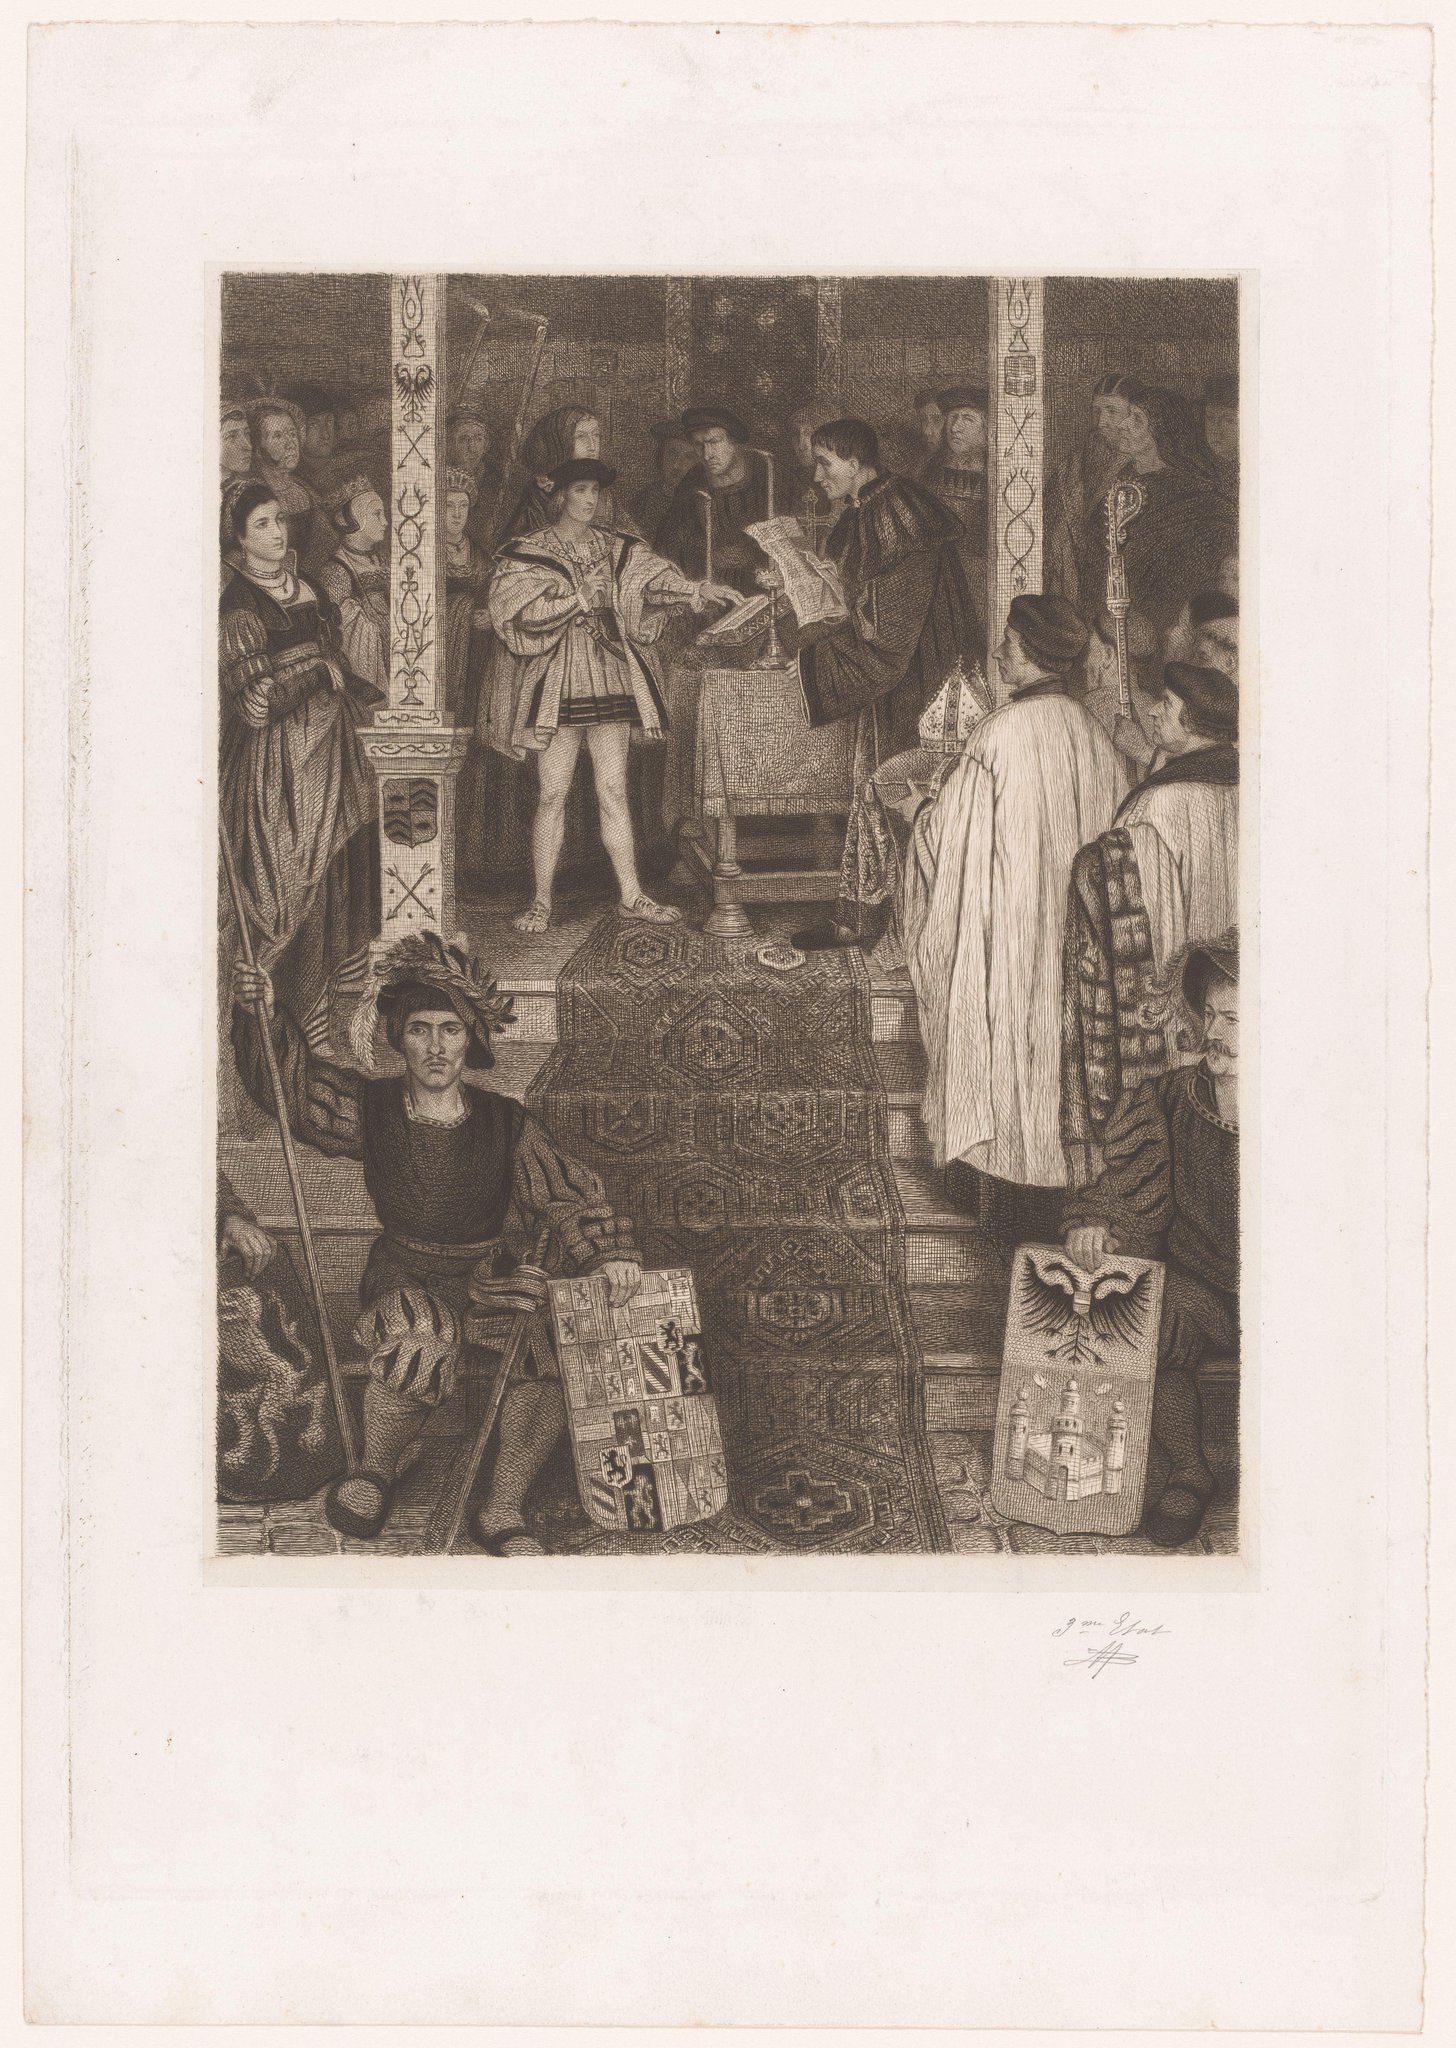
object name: print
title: Eedaflegging van keizer Karel V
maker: jean baptiste pierre michiels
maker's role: print maker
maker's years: 1821-1890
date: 1863-1890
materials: paper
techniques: etching, intaglio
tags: ghent, charles v (holy roman emperor and king of spain), ceremonial celebration of installation of a ruler, new ruler taking the oath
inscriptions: collector's mark: Lugt 2228, inscription: ‘3me Etat’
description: De prent is gemaakt naar de muurschilderingen van Henri Leys in het Stadhuis van Antwerpen. Prent verschenen in: Leys, Henri. De Zaal Leys op het Stadhuis van Antwerpen: zeven kopersneden naar de muurschilderingen van Baron H. Leys. Antwerpen: Museum Plantin-Moretus, 1902.